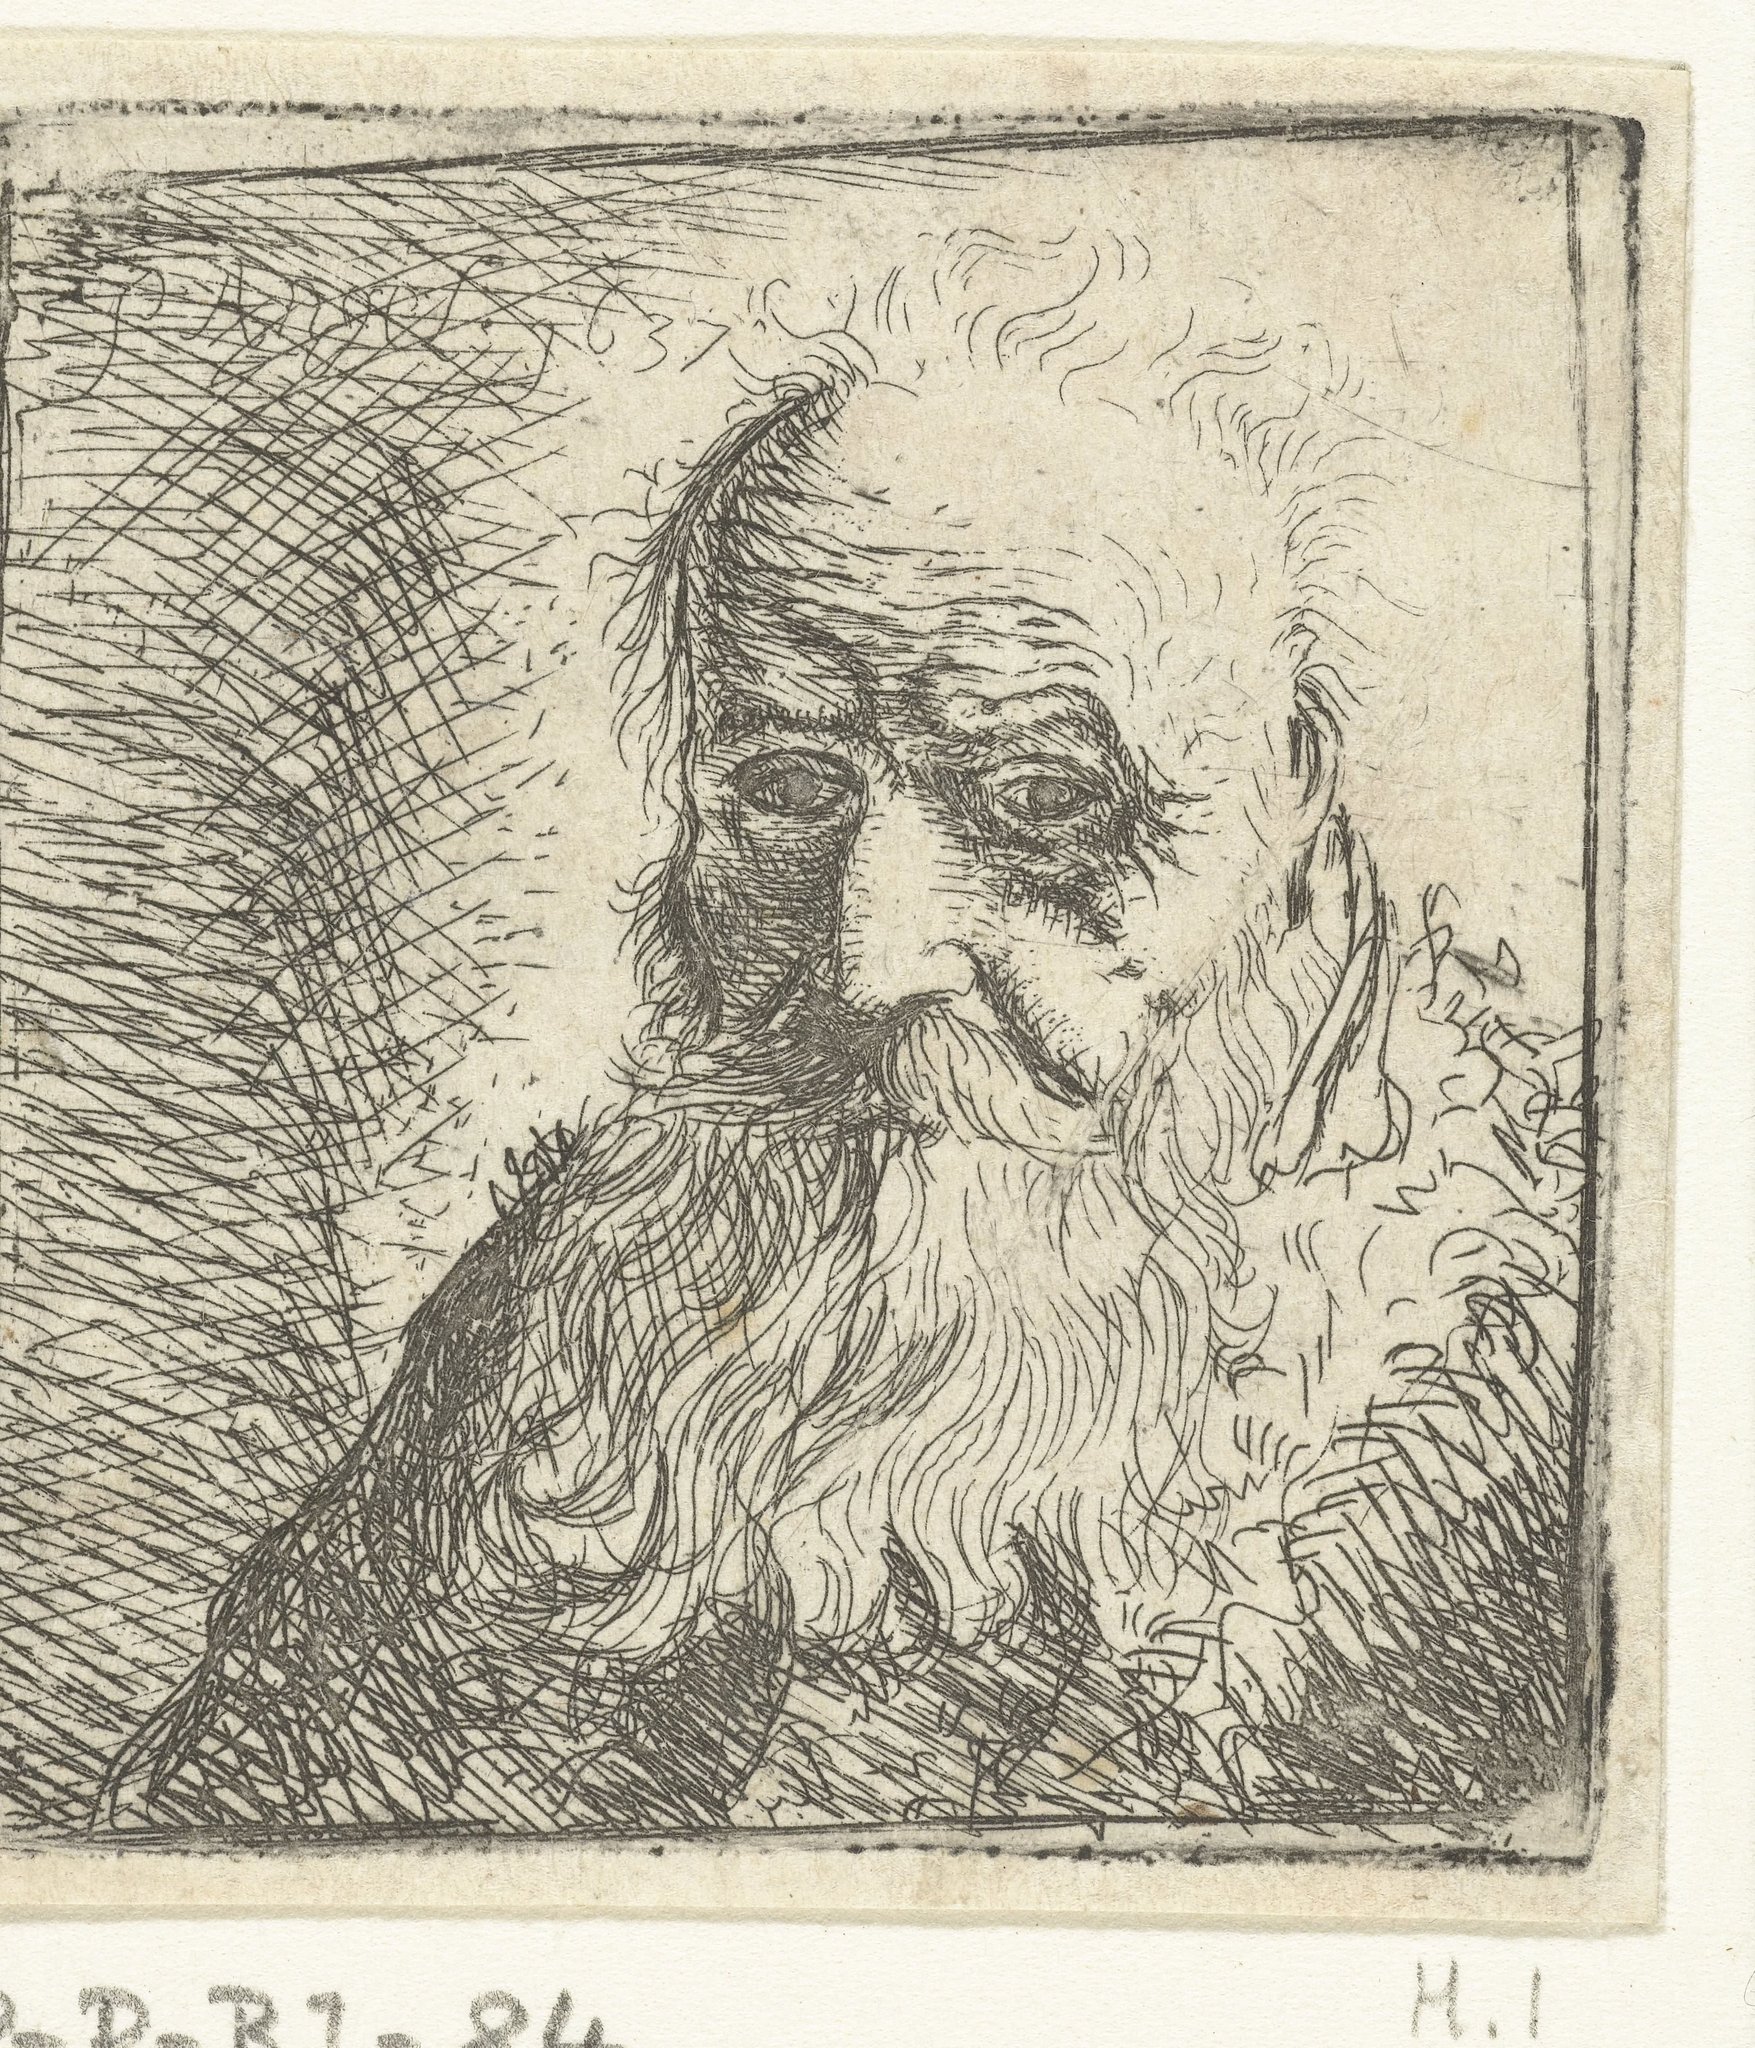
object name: print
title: Borstbeeld van een oude man met baard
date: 1639-1683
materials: paper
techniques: etching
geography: netherlands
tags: old man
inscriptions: collector's mark: Lugt 1838